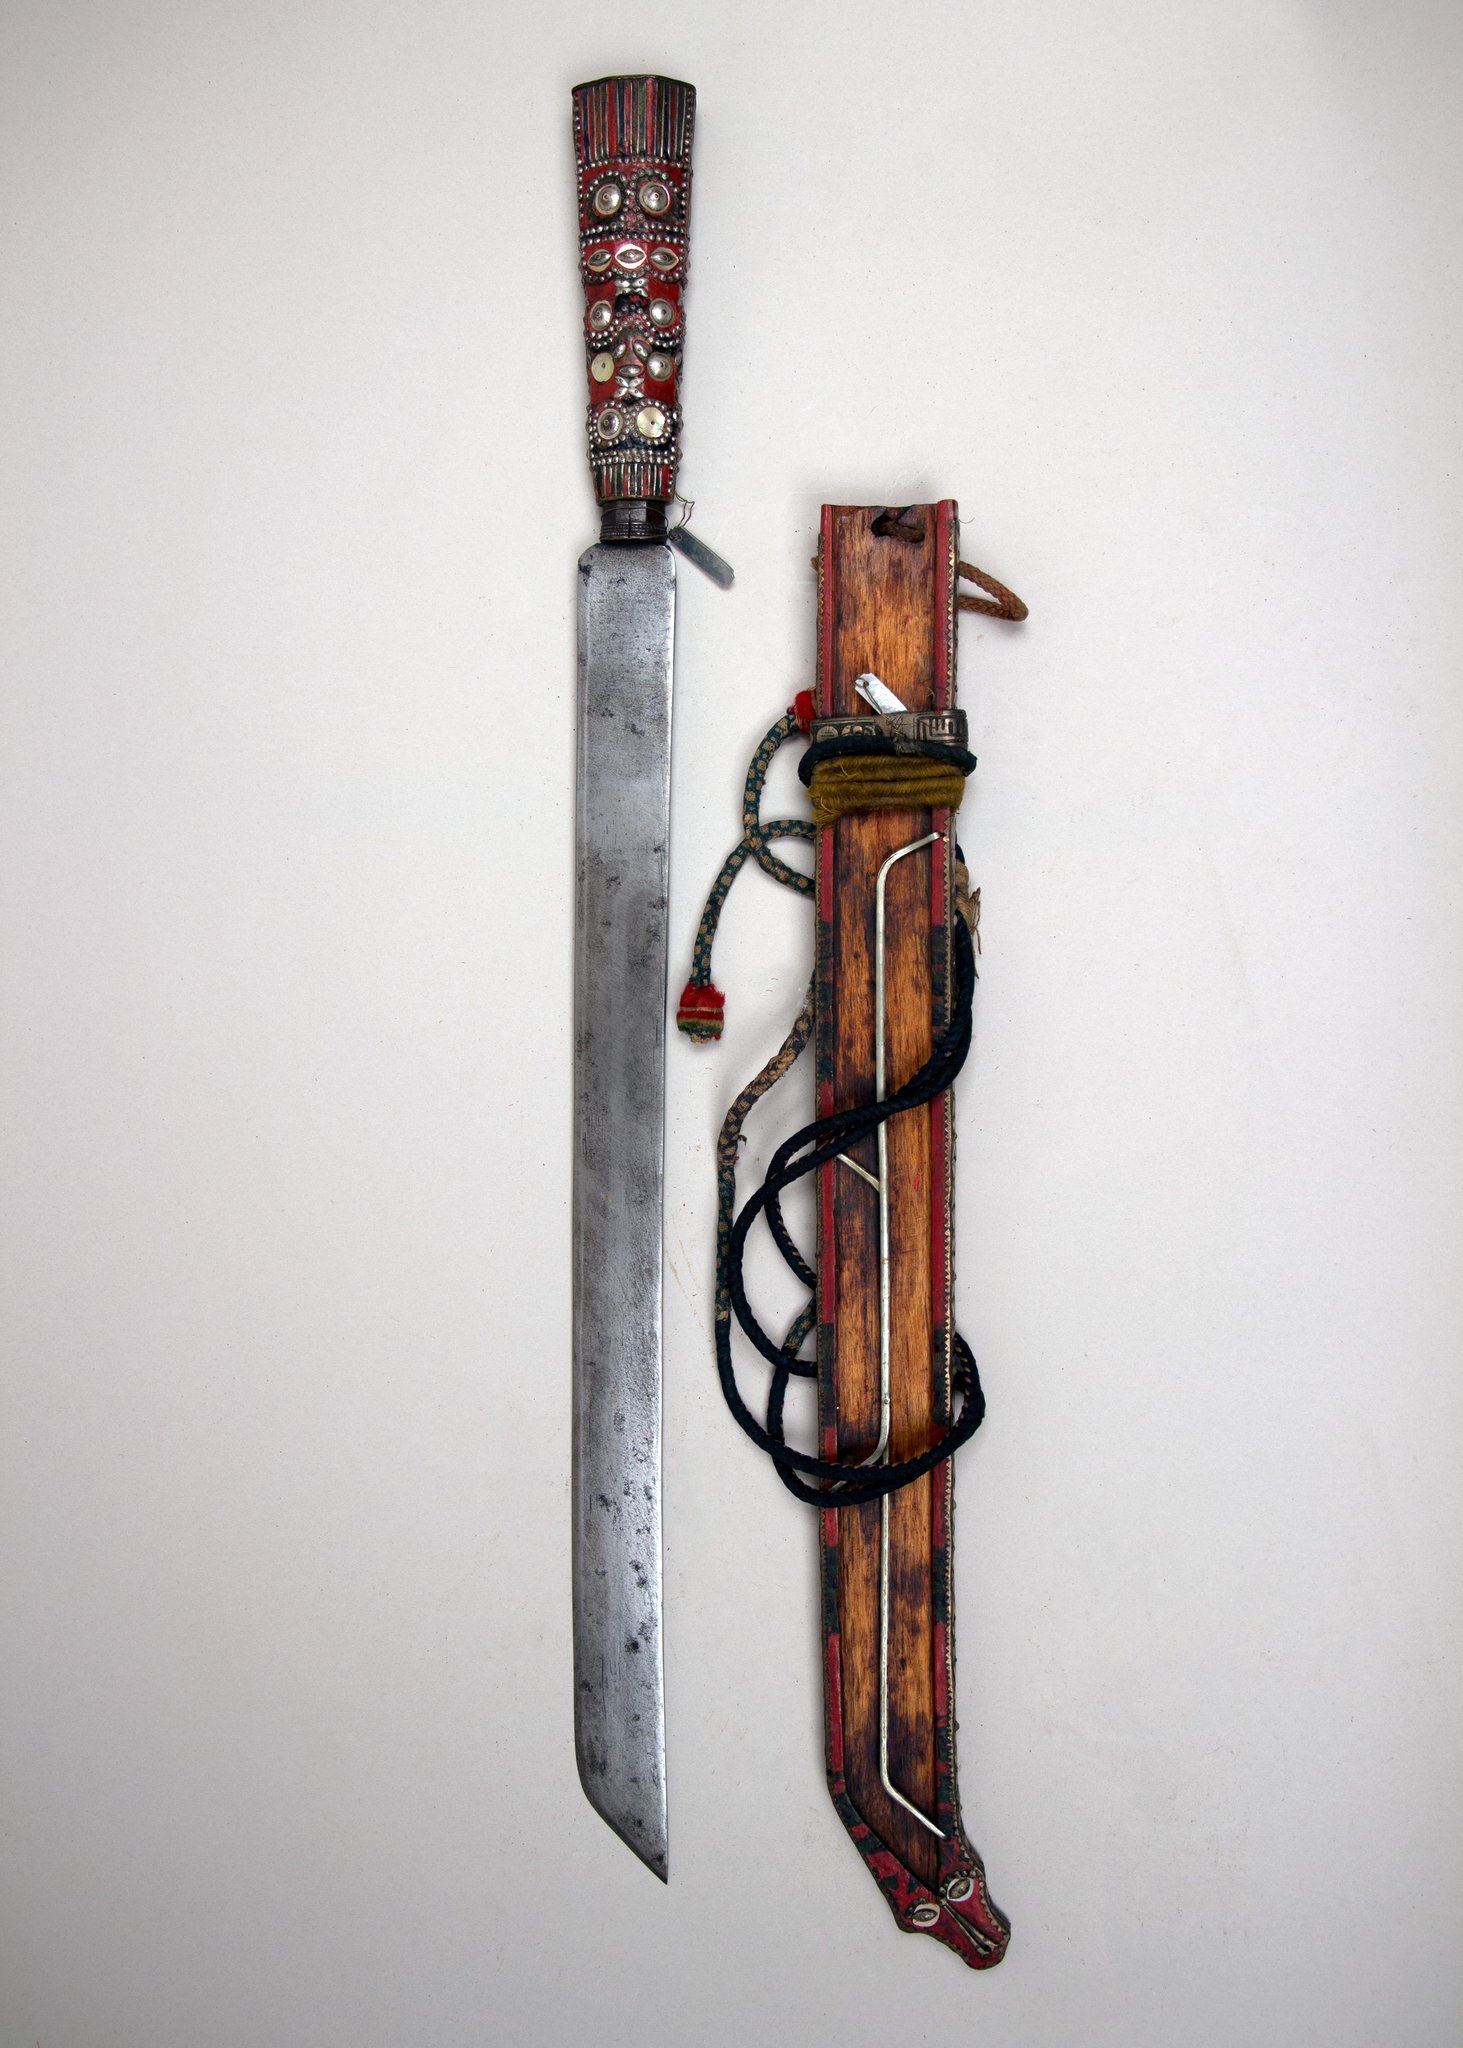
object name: sword with scabbard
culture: taiwanese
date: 1801-1900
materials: brass, cord, lacquer, silver, steel, metal, wood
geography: taiwan